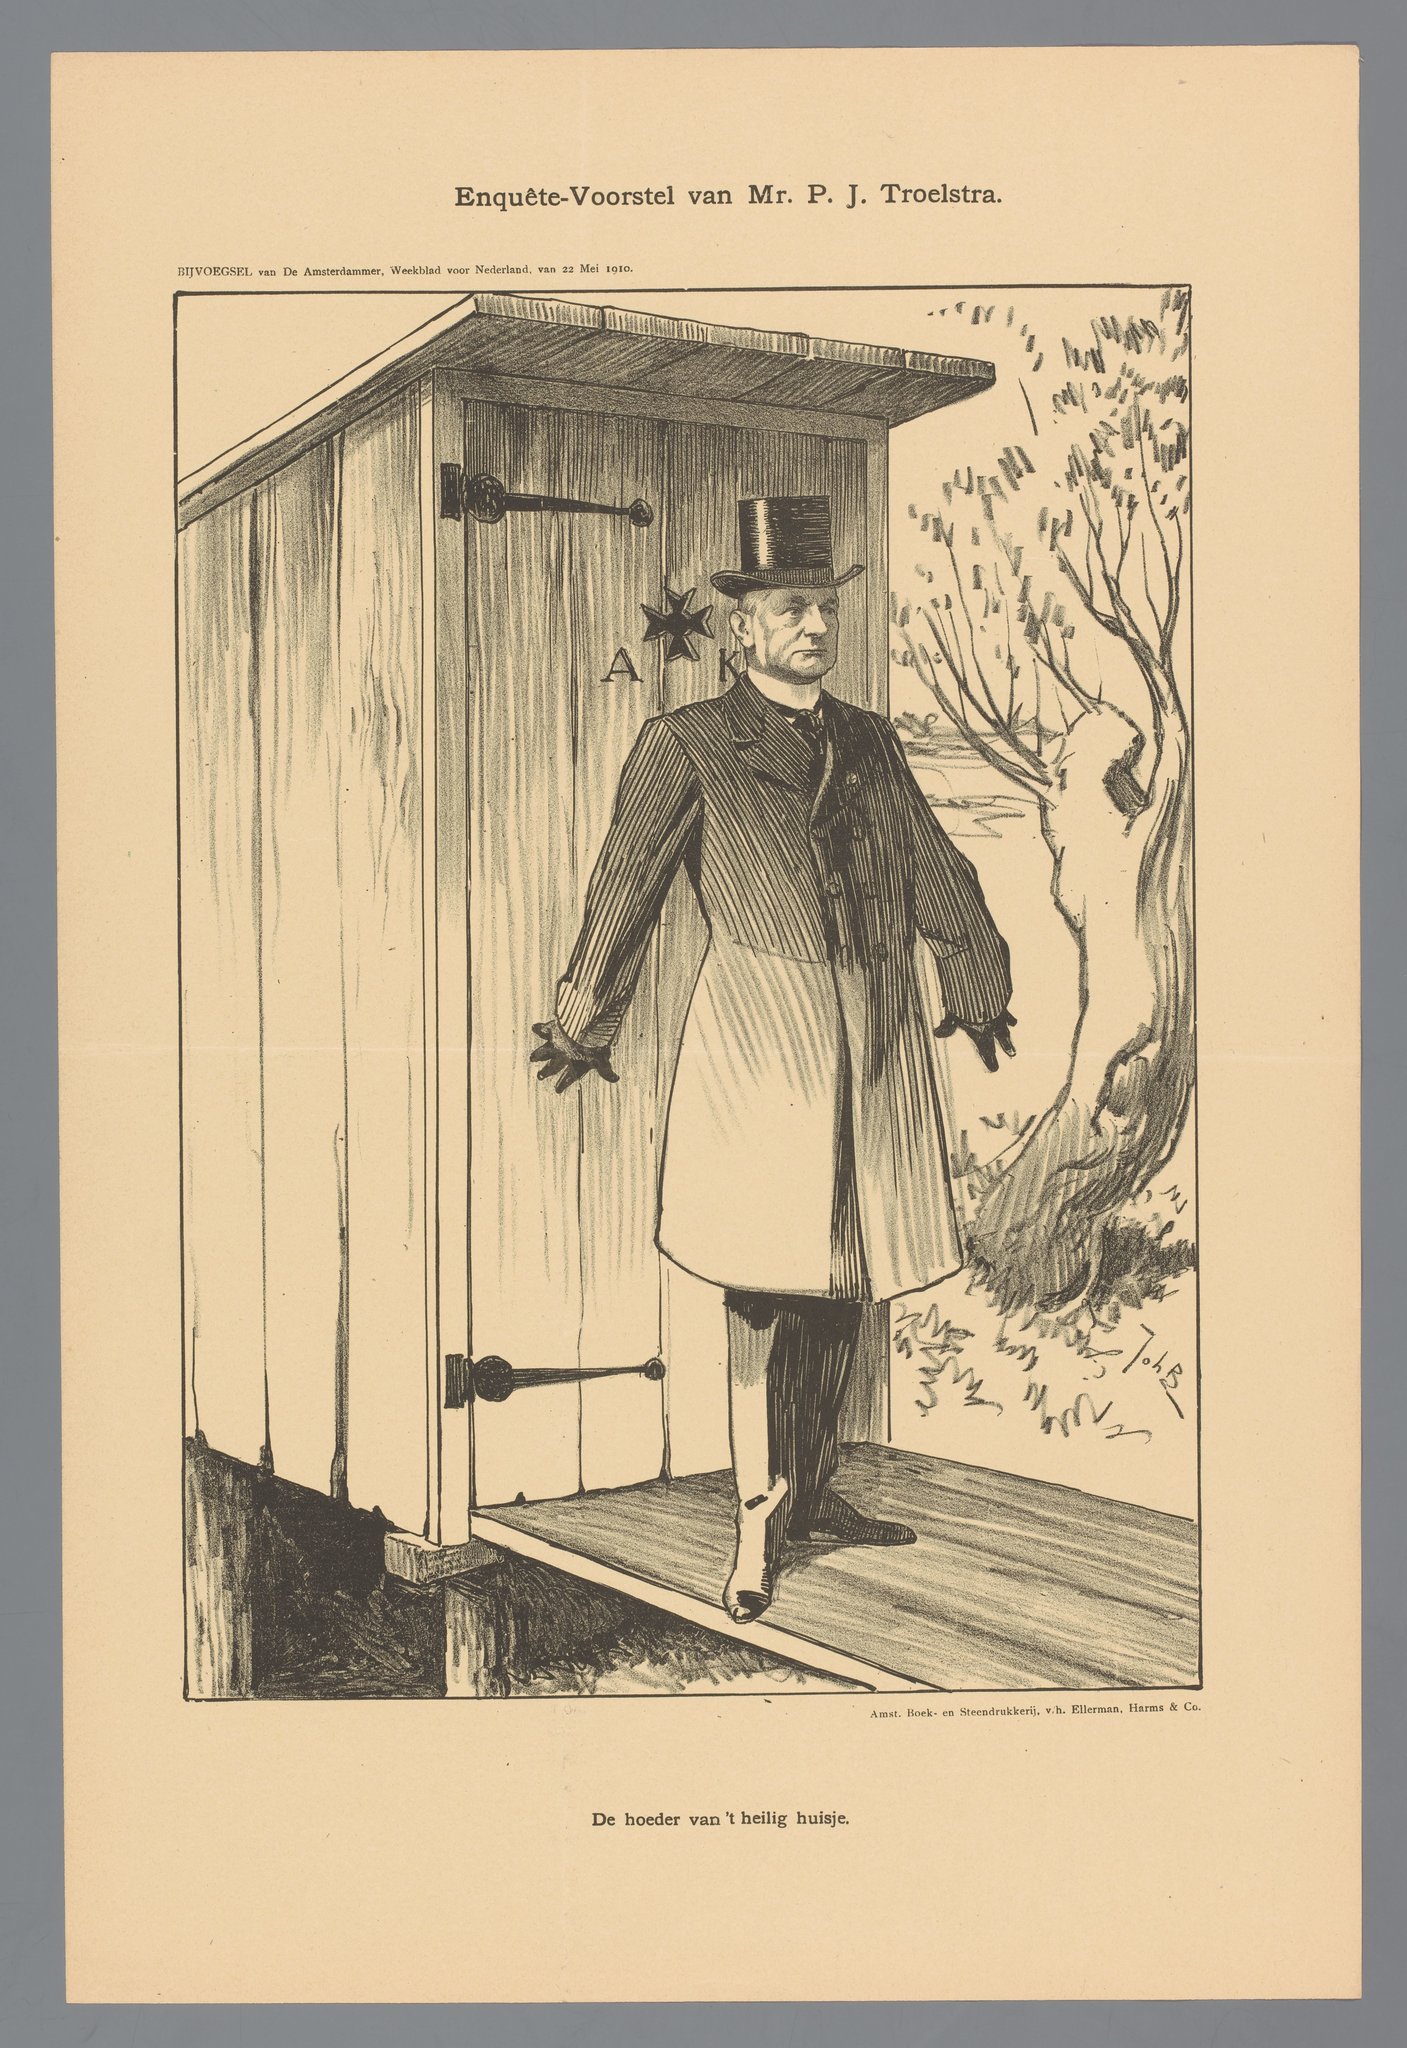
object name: cartoon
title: Enquête-Voorstel van Mr. P. J. Troelstra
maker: johan braakensiek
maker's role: draughtsman, print maker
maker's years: 1858-1940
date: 1910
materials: paper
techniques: lithograph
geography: amsterdam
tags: abraham kuyper, annexes and outbuildings; fencing; gate, lavatory, water-closet, political caricatures and satires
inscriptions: date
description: Prent uit het bijvoegsel van: De Amsterdammer. Weekblad voor Nederland, 22 mei 1910.